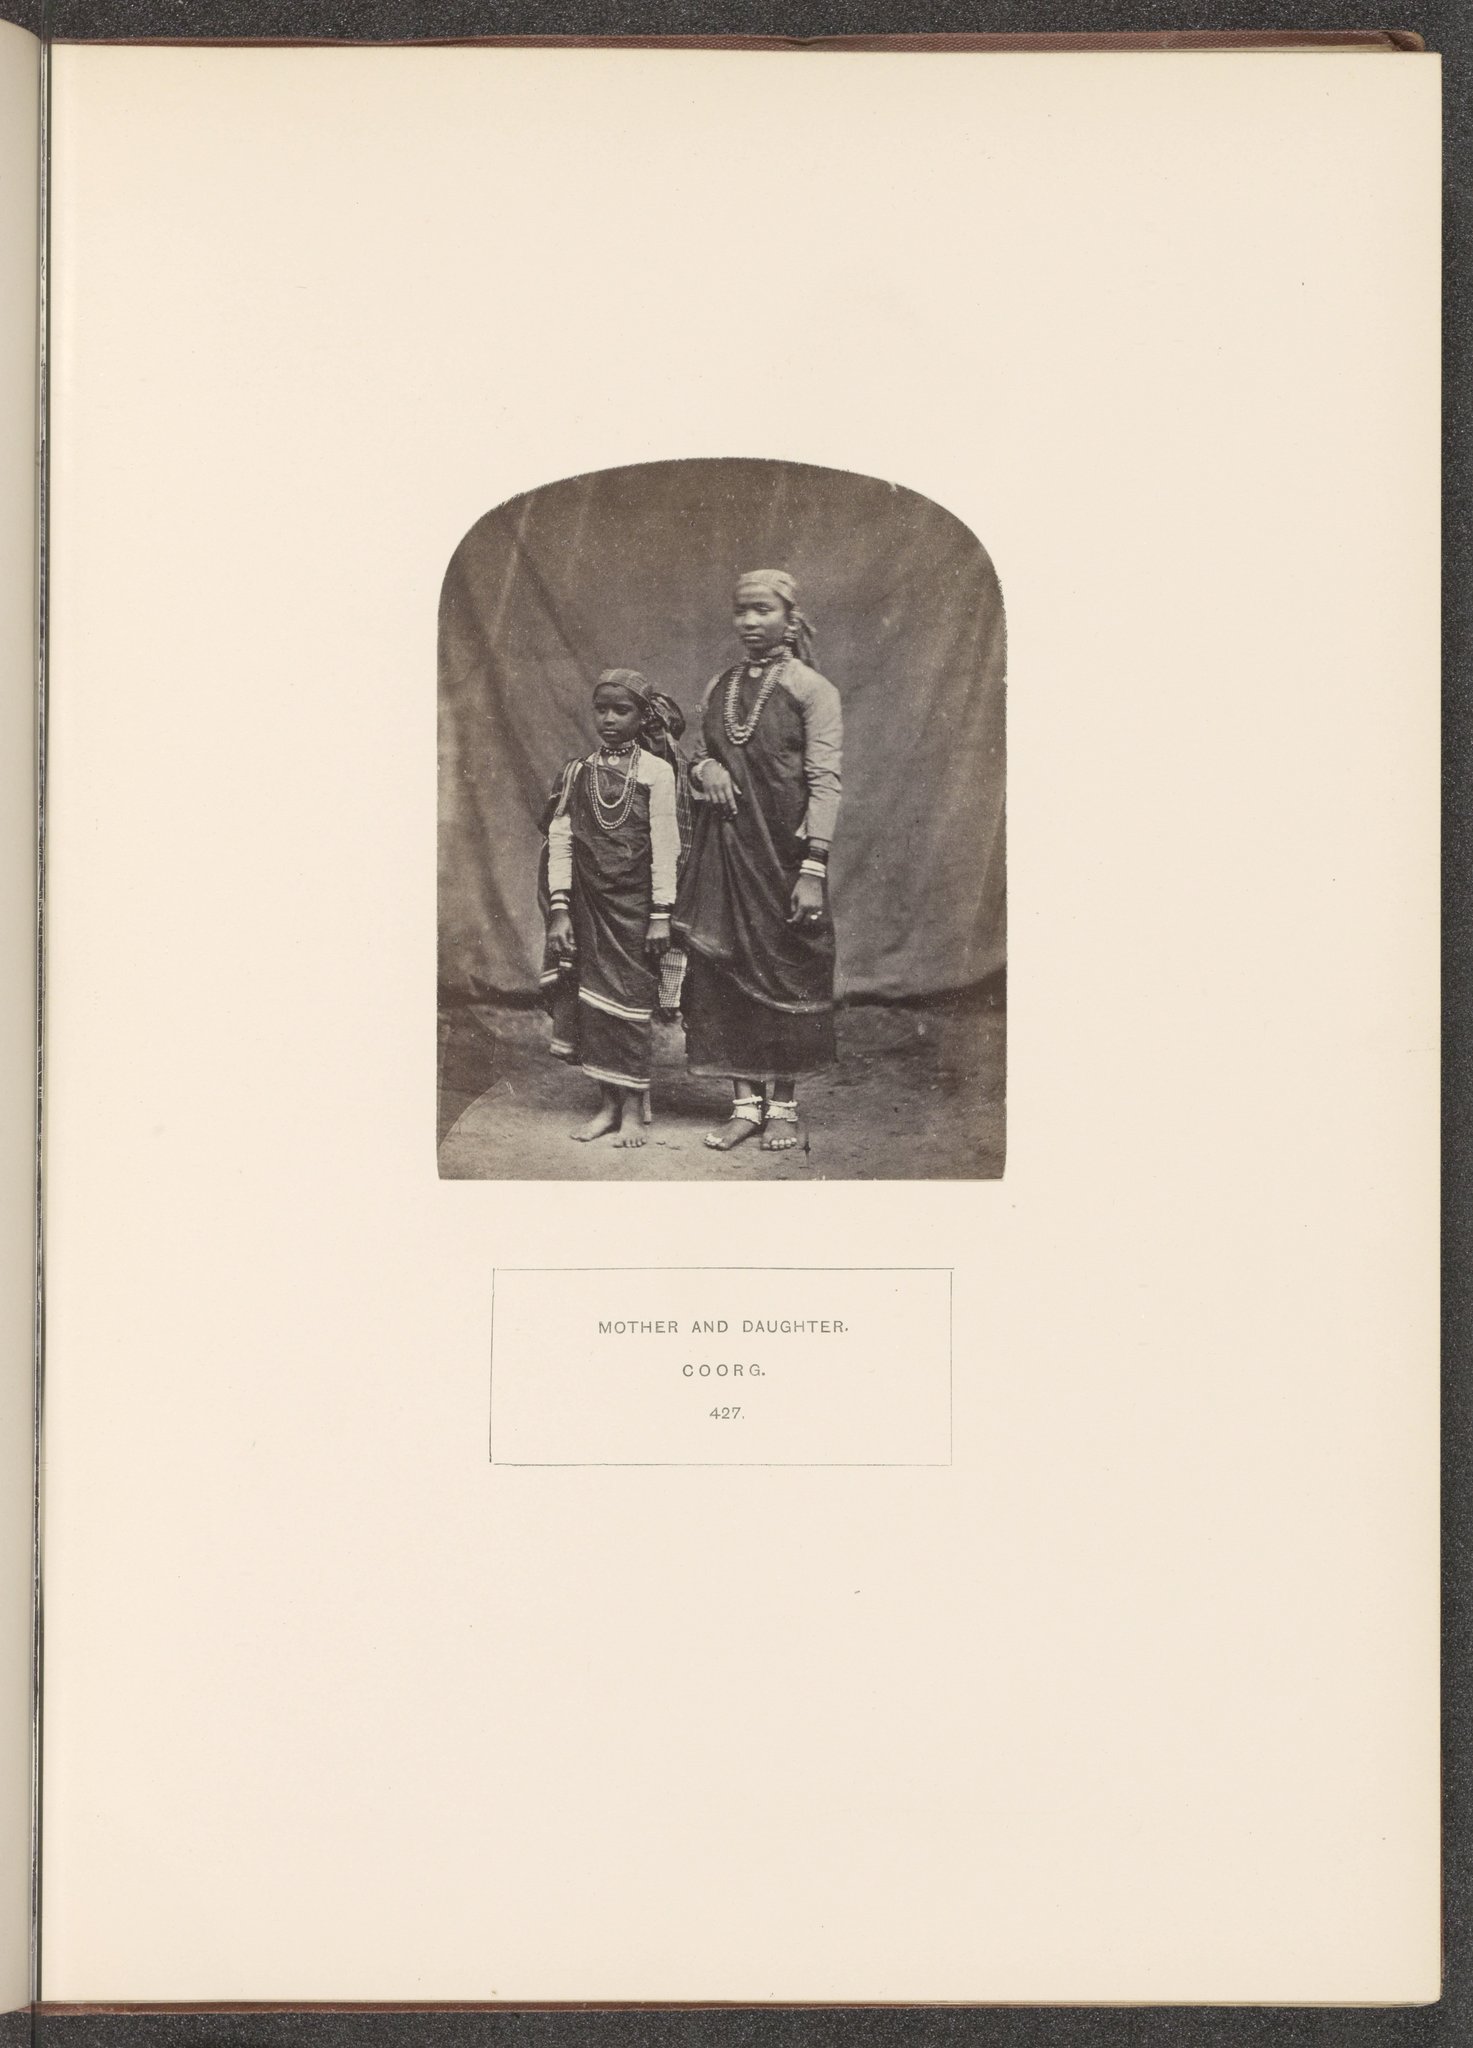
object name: page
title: Portrait of an unknown mother and daughter from the Kodava community of Kodagu, Karnataka, India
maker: g. richter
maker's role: fotograaf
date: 1865-1875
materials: photographic support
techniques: albumen print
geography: kodagu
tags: mother and daughter(s) (family group), human races; peoples; nationalities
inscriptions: number: ‘427.’, inscription: ‘MOTHER AND DAUGHTER./ COORG.’